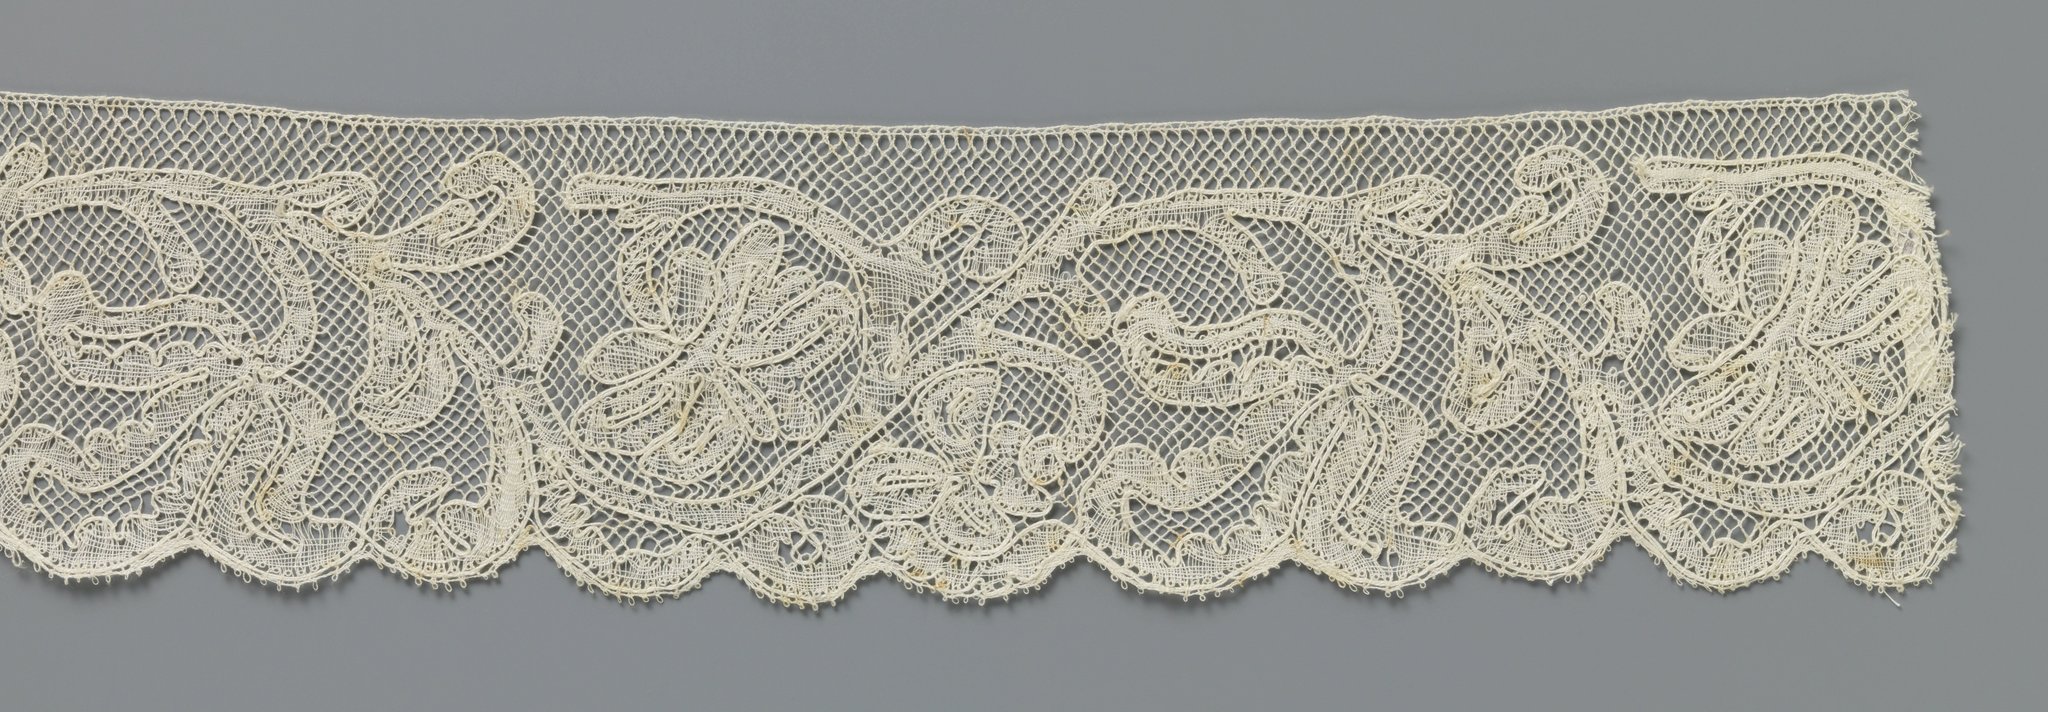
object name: strip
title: Strook kloskant met drie omkrullende takken met verschillende bloemen aan een golvende rank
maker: Anonymous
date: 1800-1899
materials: linen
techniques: lace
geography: southern netherlands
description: Strook naturelkleurige kloskant. Het zich herhalende en doorlopende patroon bestaat uit een golvende rank, met drie omkrullende zijtakken met aan elk een verschillende bloem. Behalve de bloemen zitten er enkele afgeronde stompe blaadjes of zijtakjes aan de rank en enkele vergelijkbare, maar iets langere en omkrullende blaadjes. De motieven zijn gemaakt in losgewerkte linnenslag met dubbele contourdraden en zijn met elkaar verbonden door een ruitvormige traliegrond: een stroptraliegrond. De bovenzijde van de strook is recht afgewerkt. De schulpenrand langs de onderzijde komt voort uit het patroon en is afgewerkt met picots.